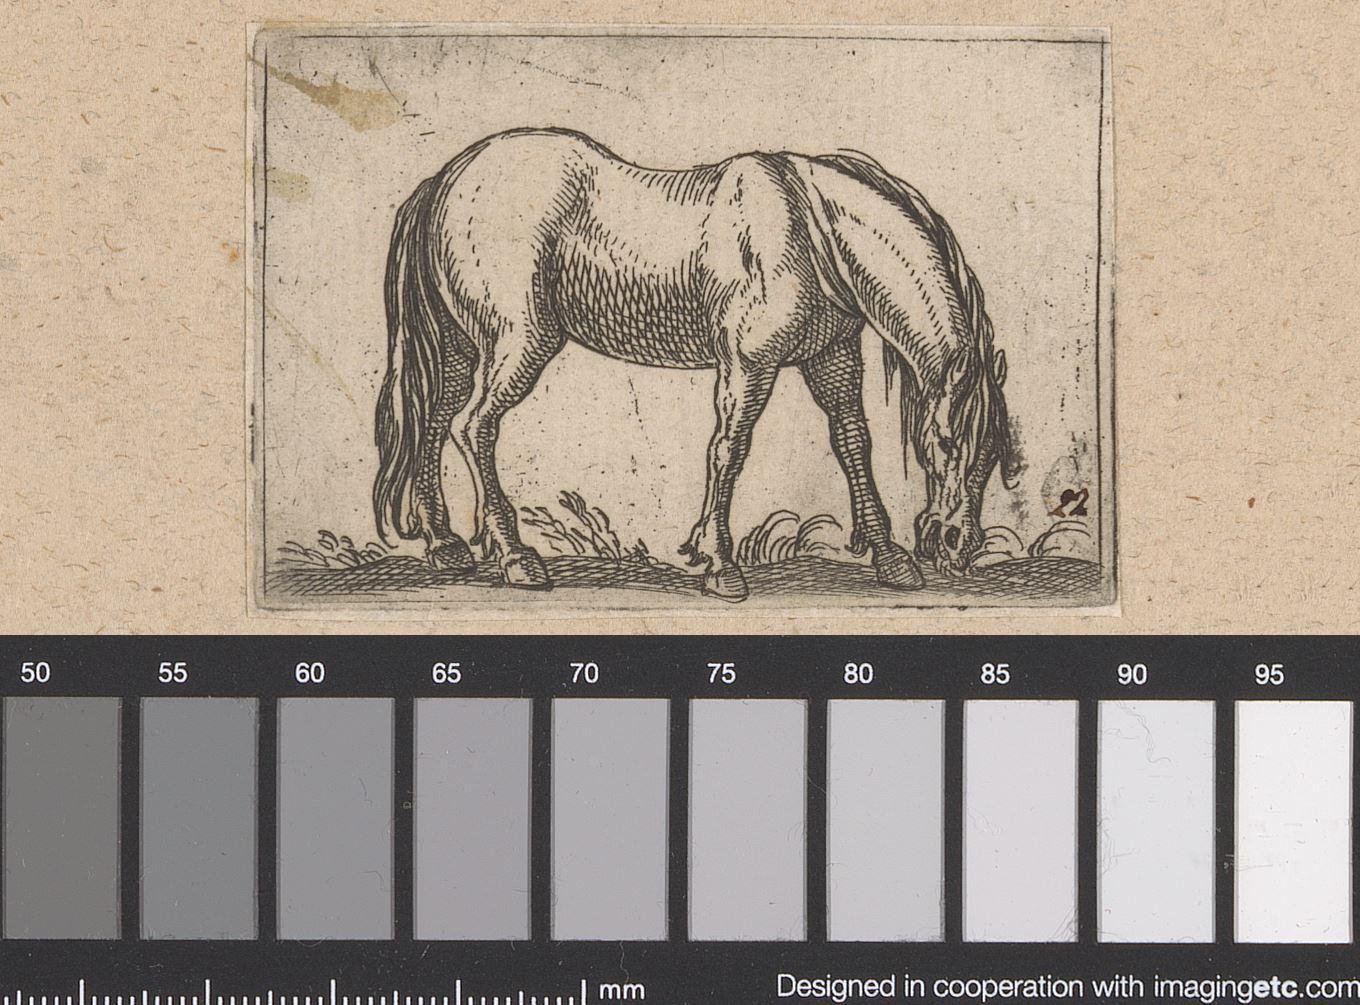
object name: print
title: Paarden in verschillende houdingen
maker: antonio tempesta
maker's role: draughtsman, painter, print maker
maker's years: 1555-1630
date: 1565-1630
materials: paper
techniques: etching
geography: italy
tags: horse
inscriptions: number: ‘22’, collector's mark: Lugt 11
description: Deze prent maakt deel uit van een reeks van 24 prenten van paarden.